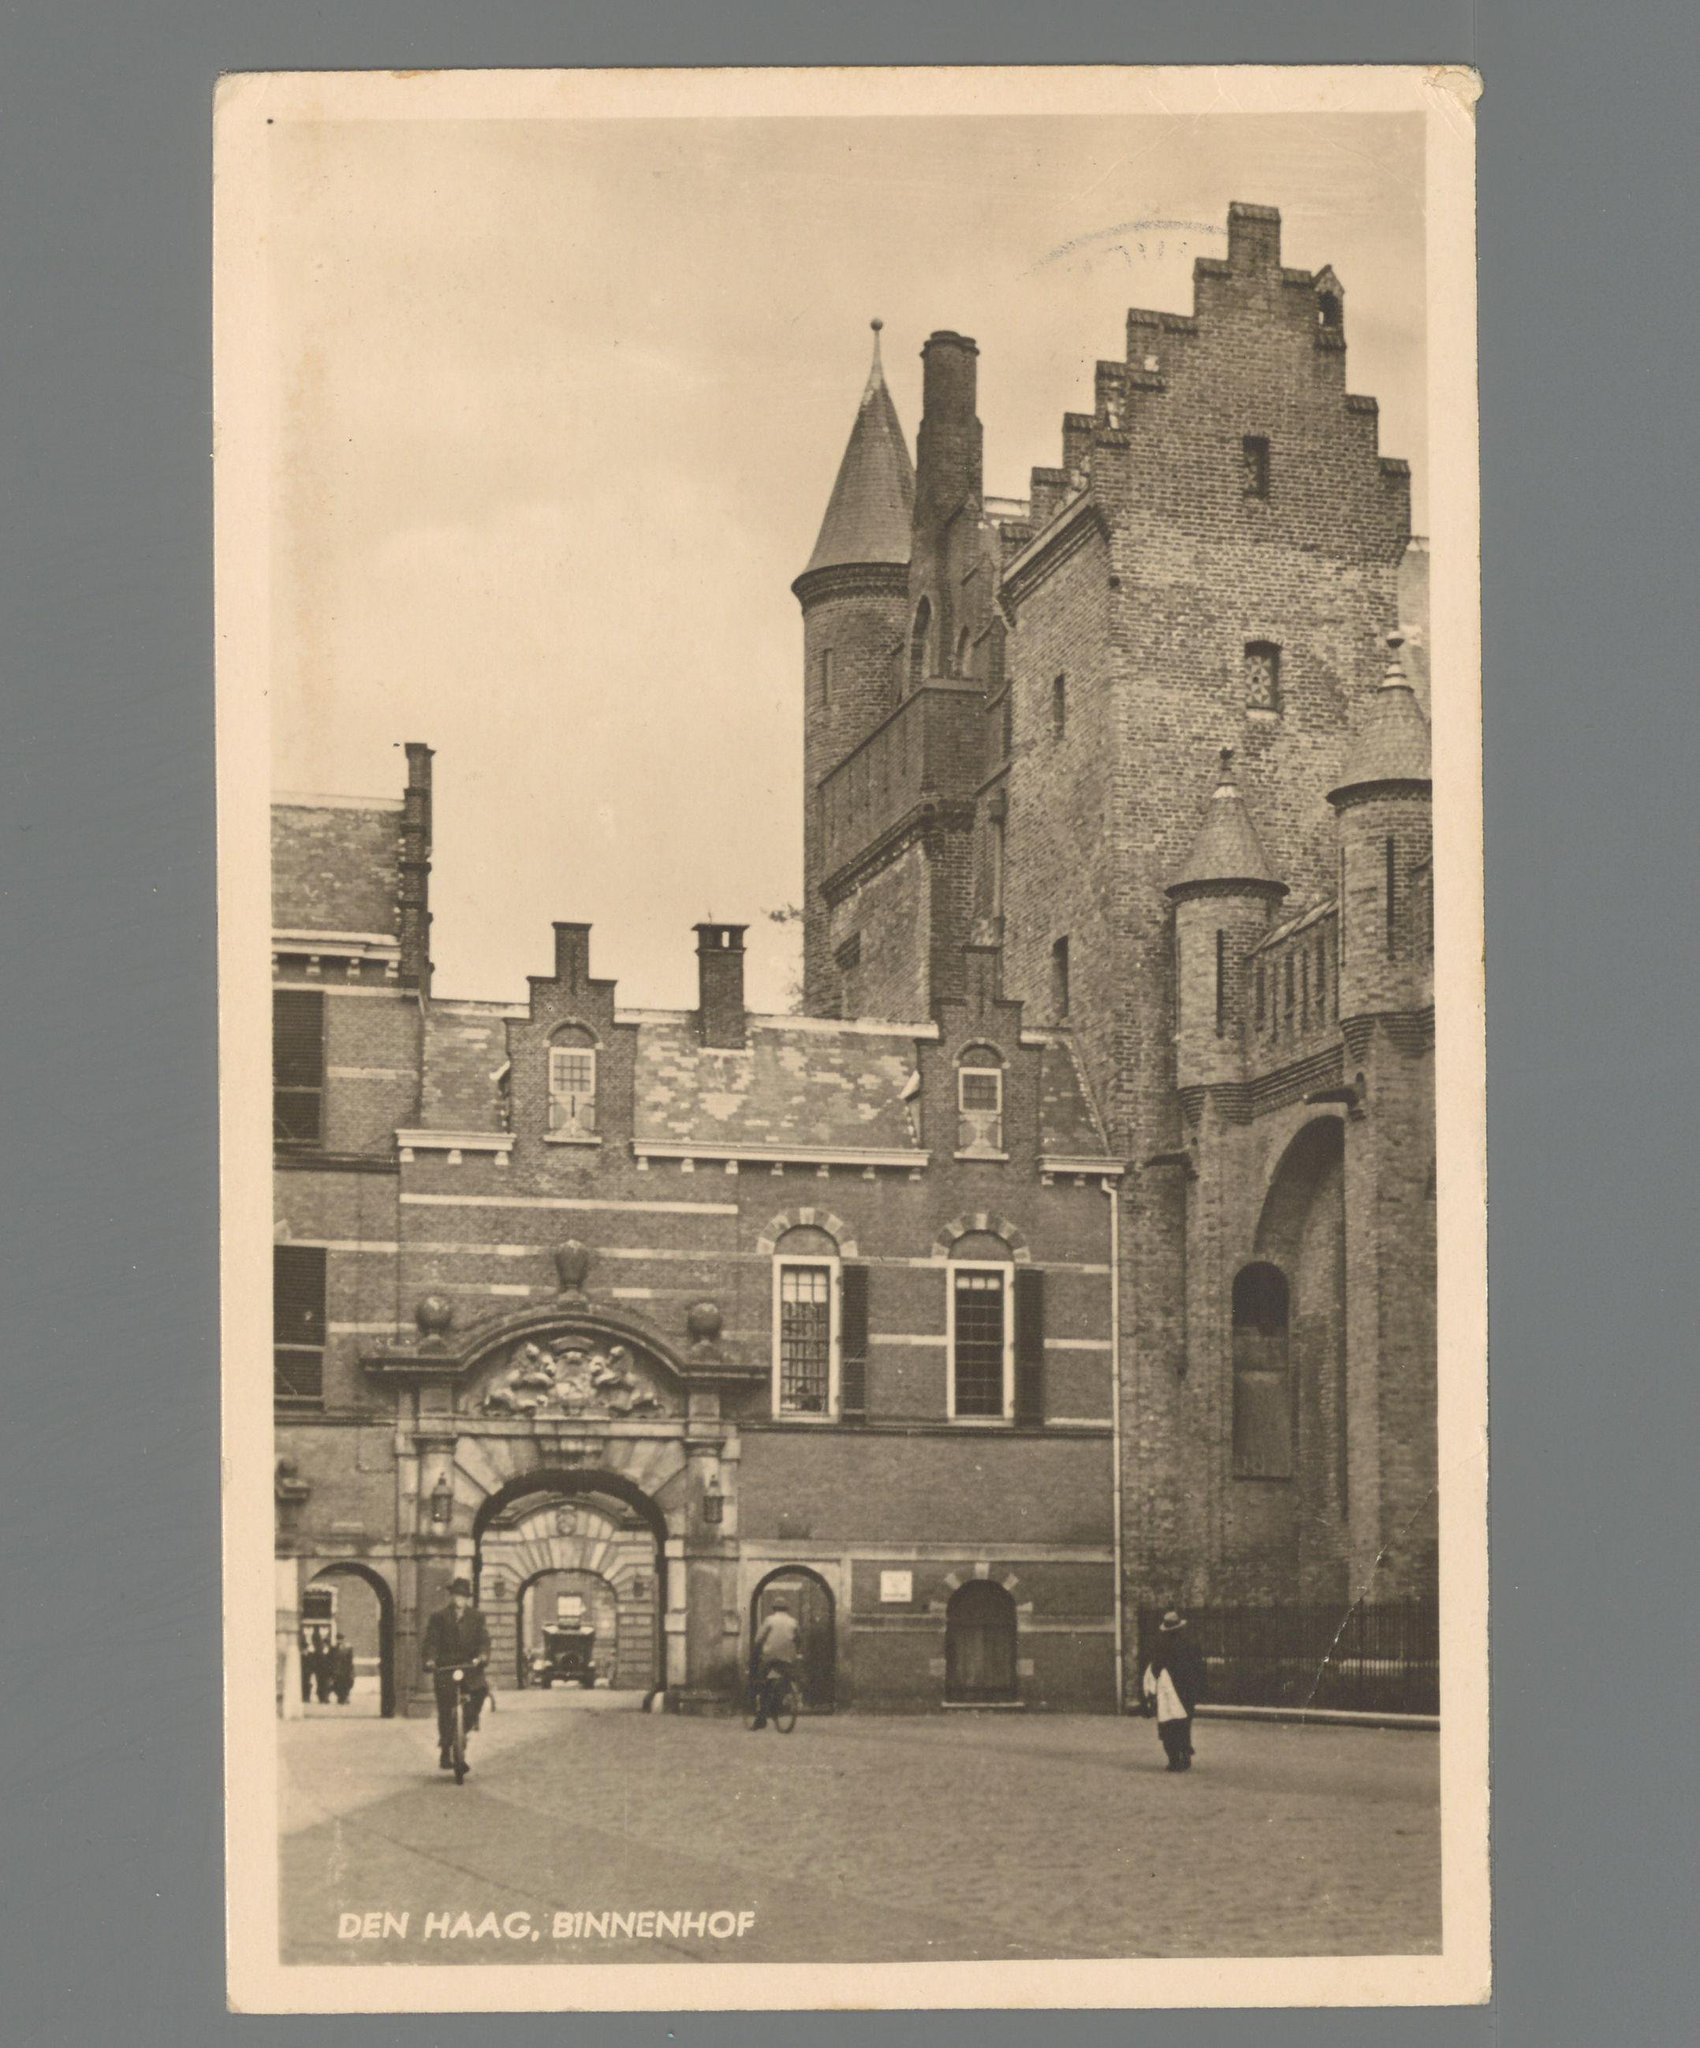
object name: photograph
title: Den Haag, Binnenhof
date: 1929-1936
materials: photographic support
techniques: gelatin silver print, writing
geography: the hague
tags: city-view, and landscape with man-made constructions, gate, entrance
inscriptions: poststempel, verso, gestempeld